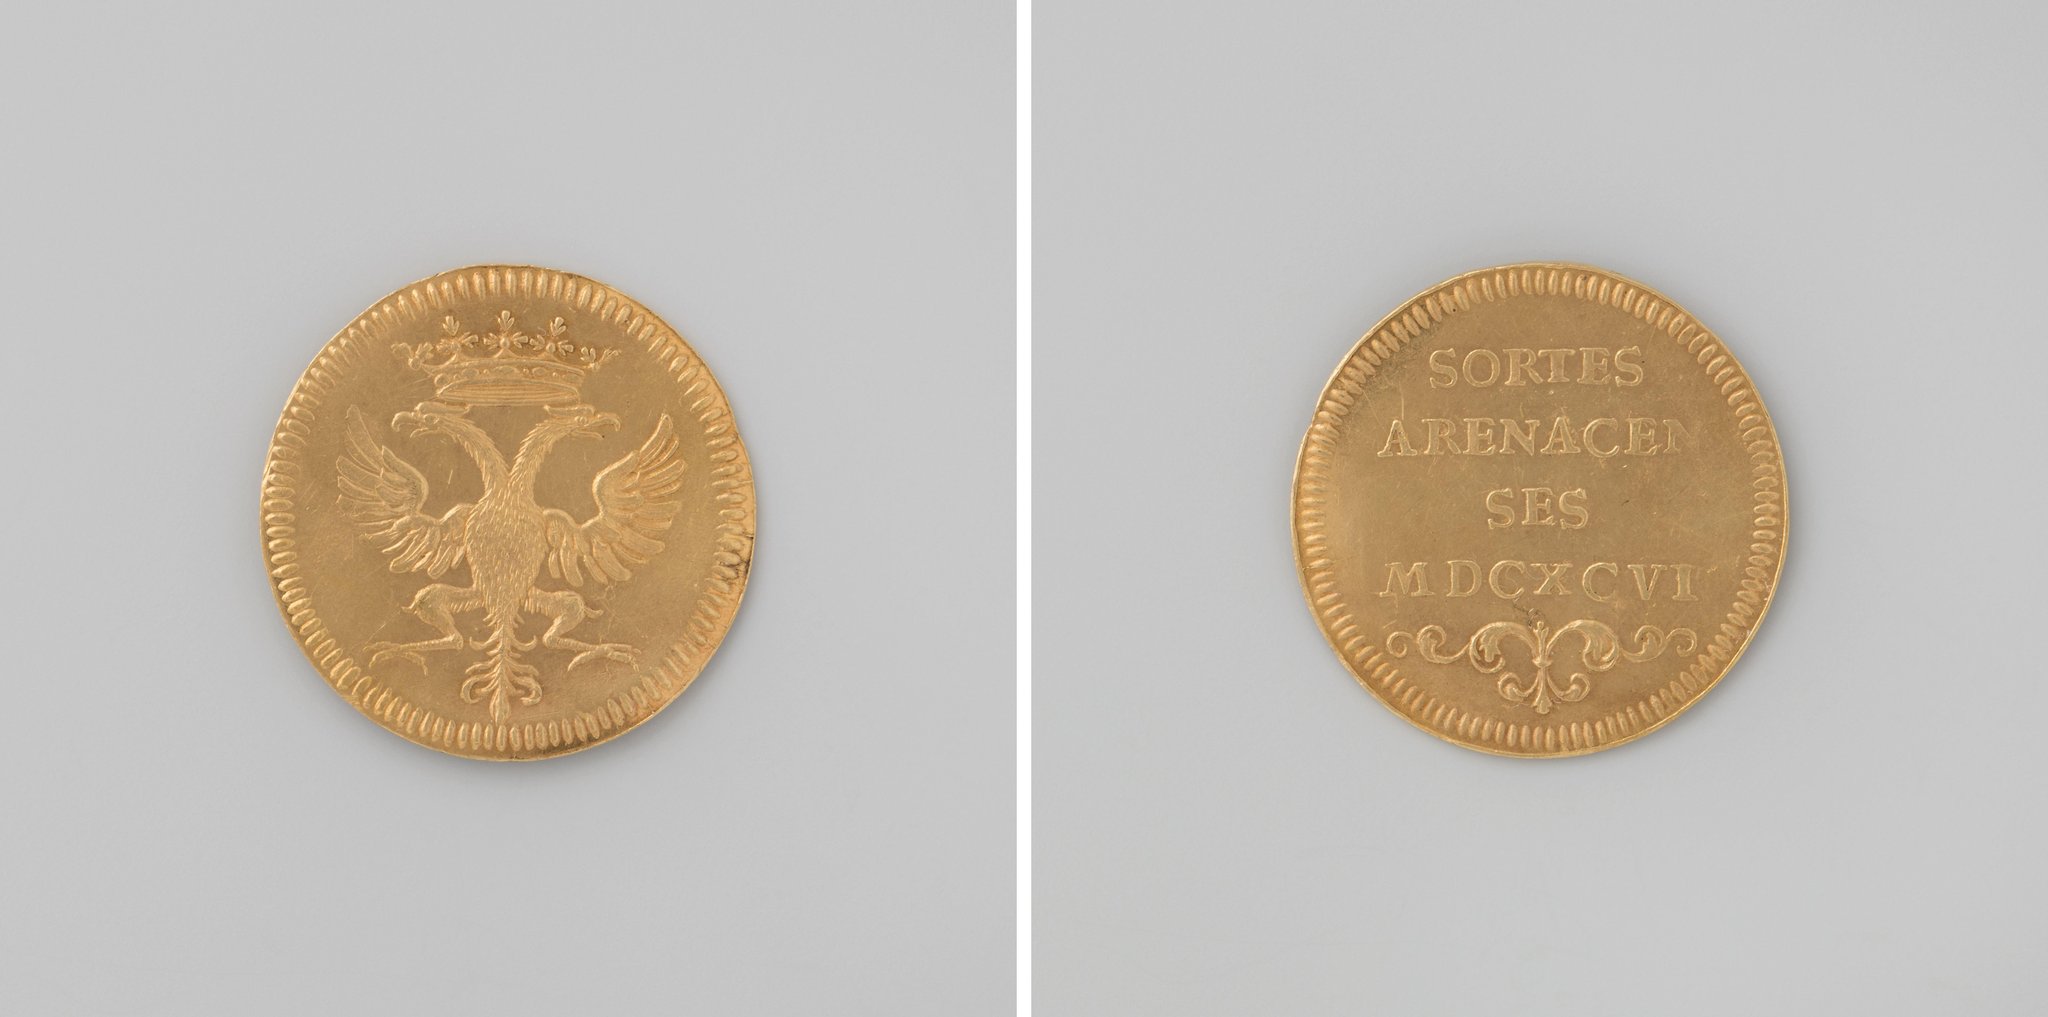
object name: history medal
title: Trekking van de loterij te Arnhem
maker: Anonymous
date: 1696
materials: gold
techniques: striking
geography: netherlands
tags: arnhem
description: Gouden penning. Voorzijde: dubbelhoofdige adelaar onder kroon . Keerzijde: opschrift